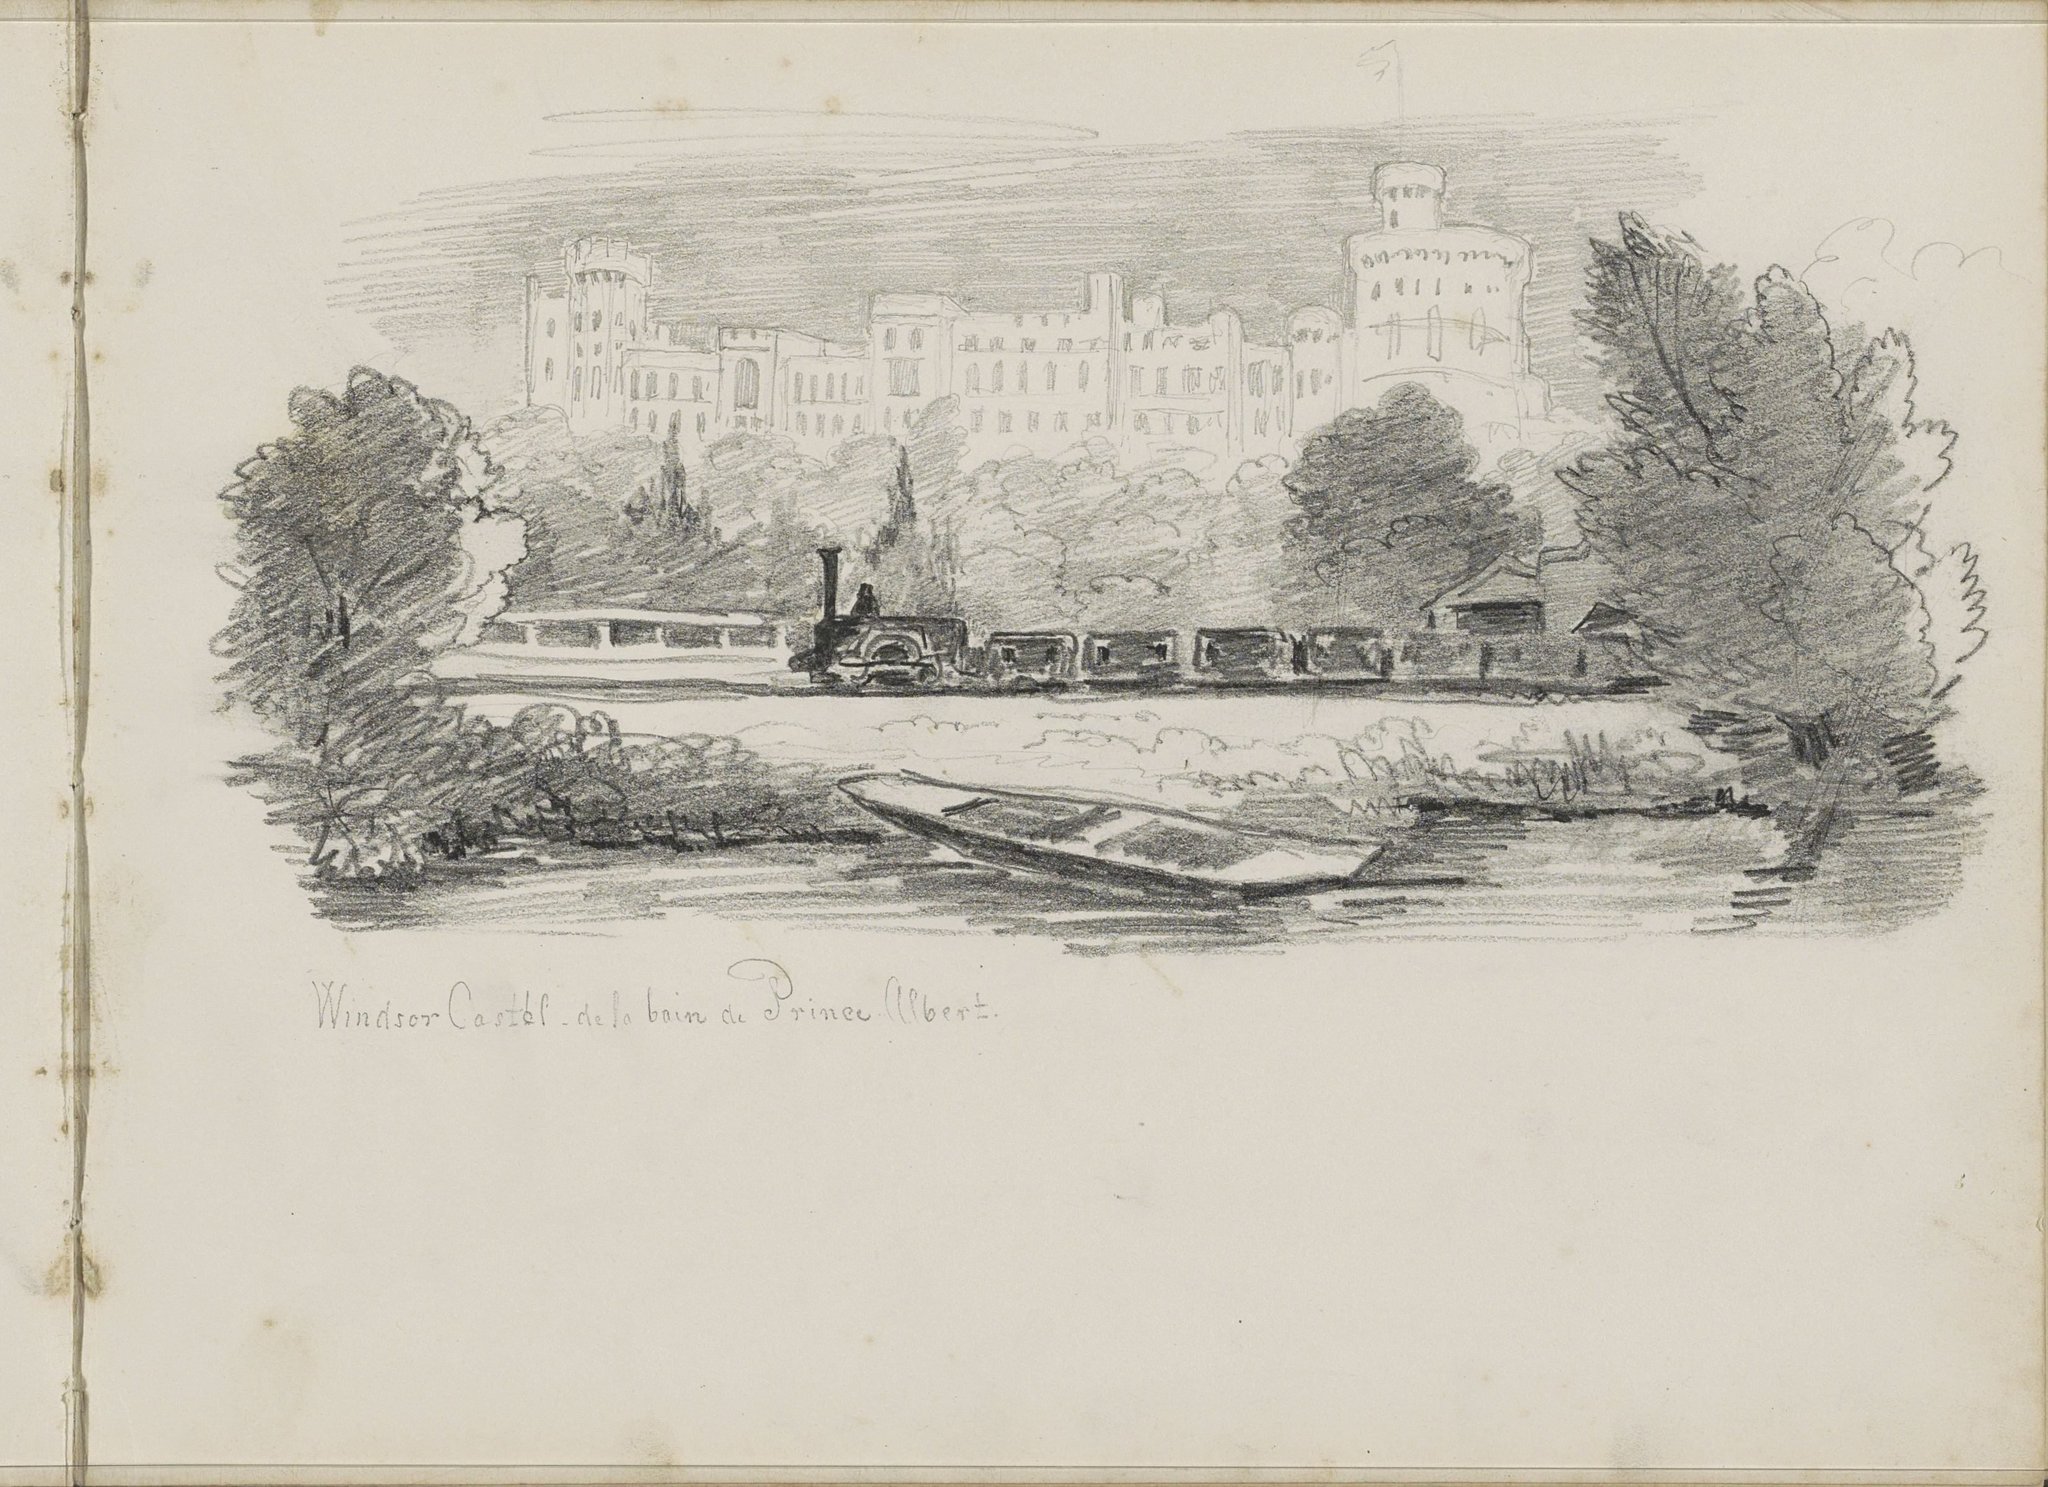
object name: sketchbook leaf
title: Windsor Castle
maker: gerrit postma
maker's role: draughtsman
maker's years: 1819-1894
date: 1858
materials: paper, pencil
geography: windsor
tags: castle, palace, steam locomotive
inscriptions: annotation: ‘Windsor Castel - de la bain de Prince Albert.’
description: Op de voorgrond een stoomtrein en de rivier de Thames. Blad 46 recto uit een schetsboek met 52 bladen.